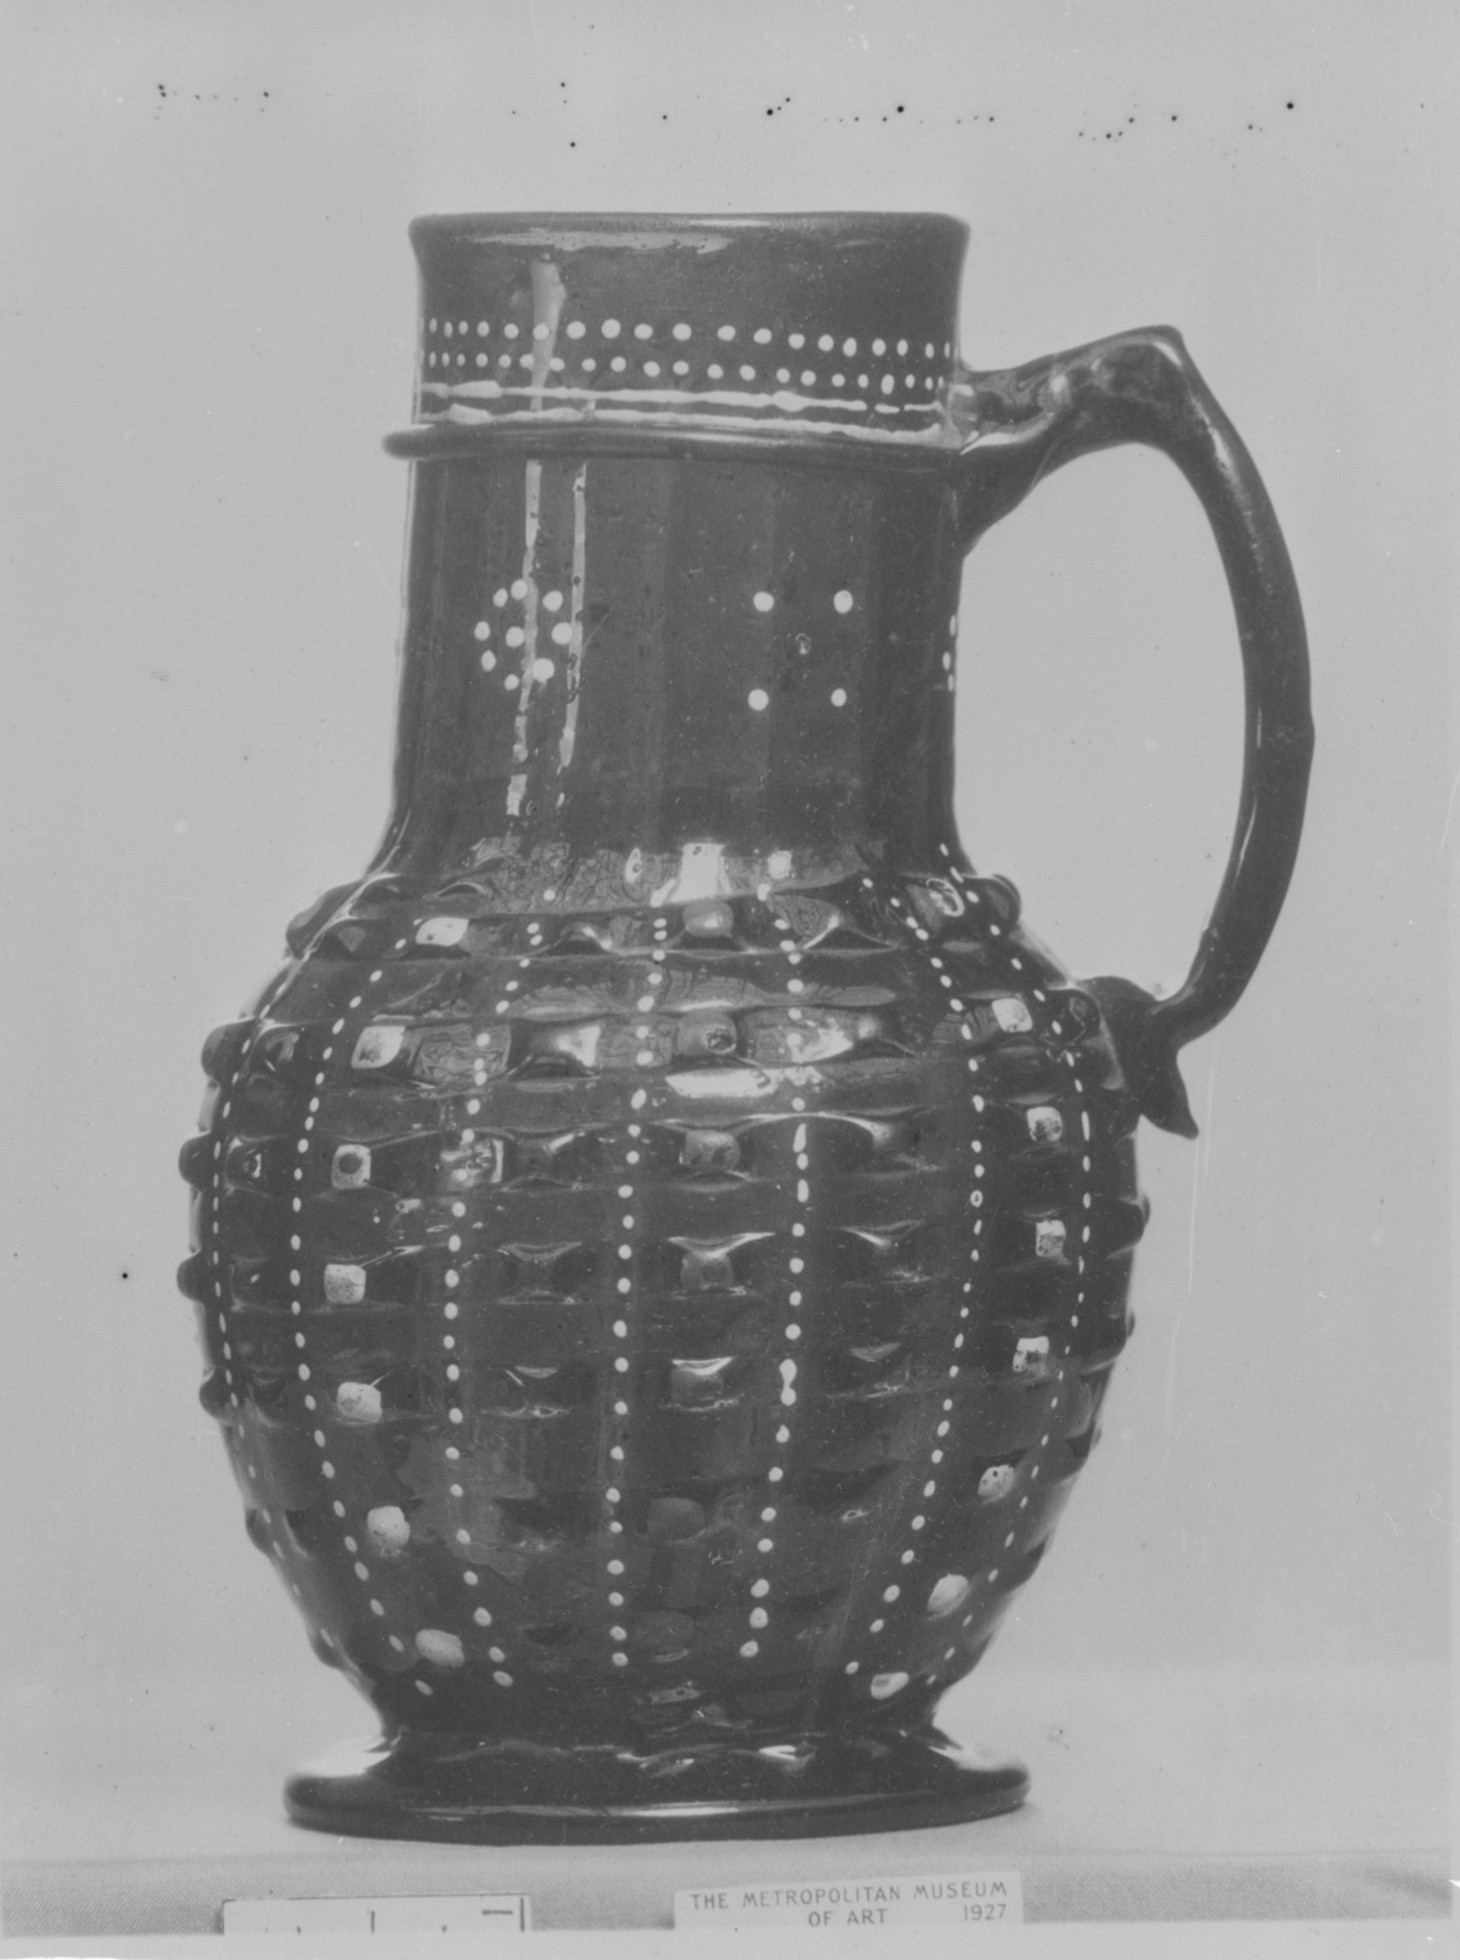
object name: tankard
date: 1567-1633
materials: glass